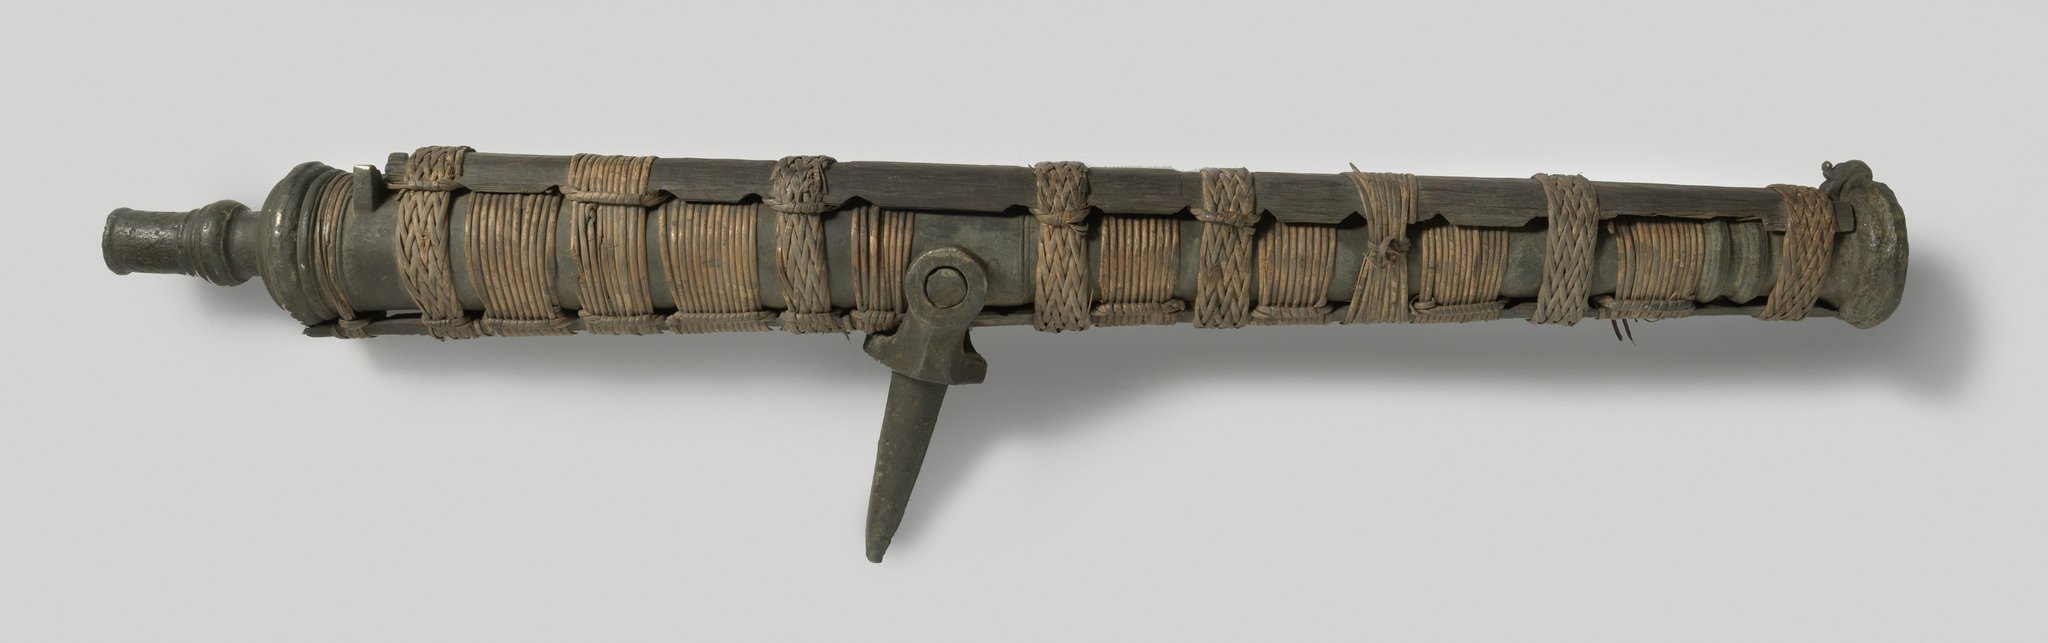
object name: lilla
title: Swivel Gun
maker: Anonymous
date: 1750-1850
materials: bamboo, bronze, rattan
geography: indonesian archipelago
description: After Java was brought entirely under Dutch rule during the Java War (1825–1830), the Dutch sought to gain control of the other Indonesian islands as well. Various military expeditions were mounted to force the rulers of these islands to recognize Dutch authority. These cannons were seized during those battles. One is an old Dutch East India Company cannon of 1667.